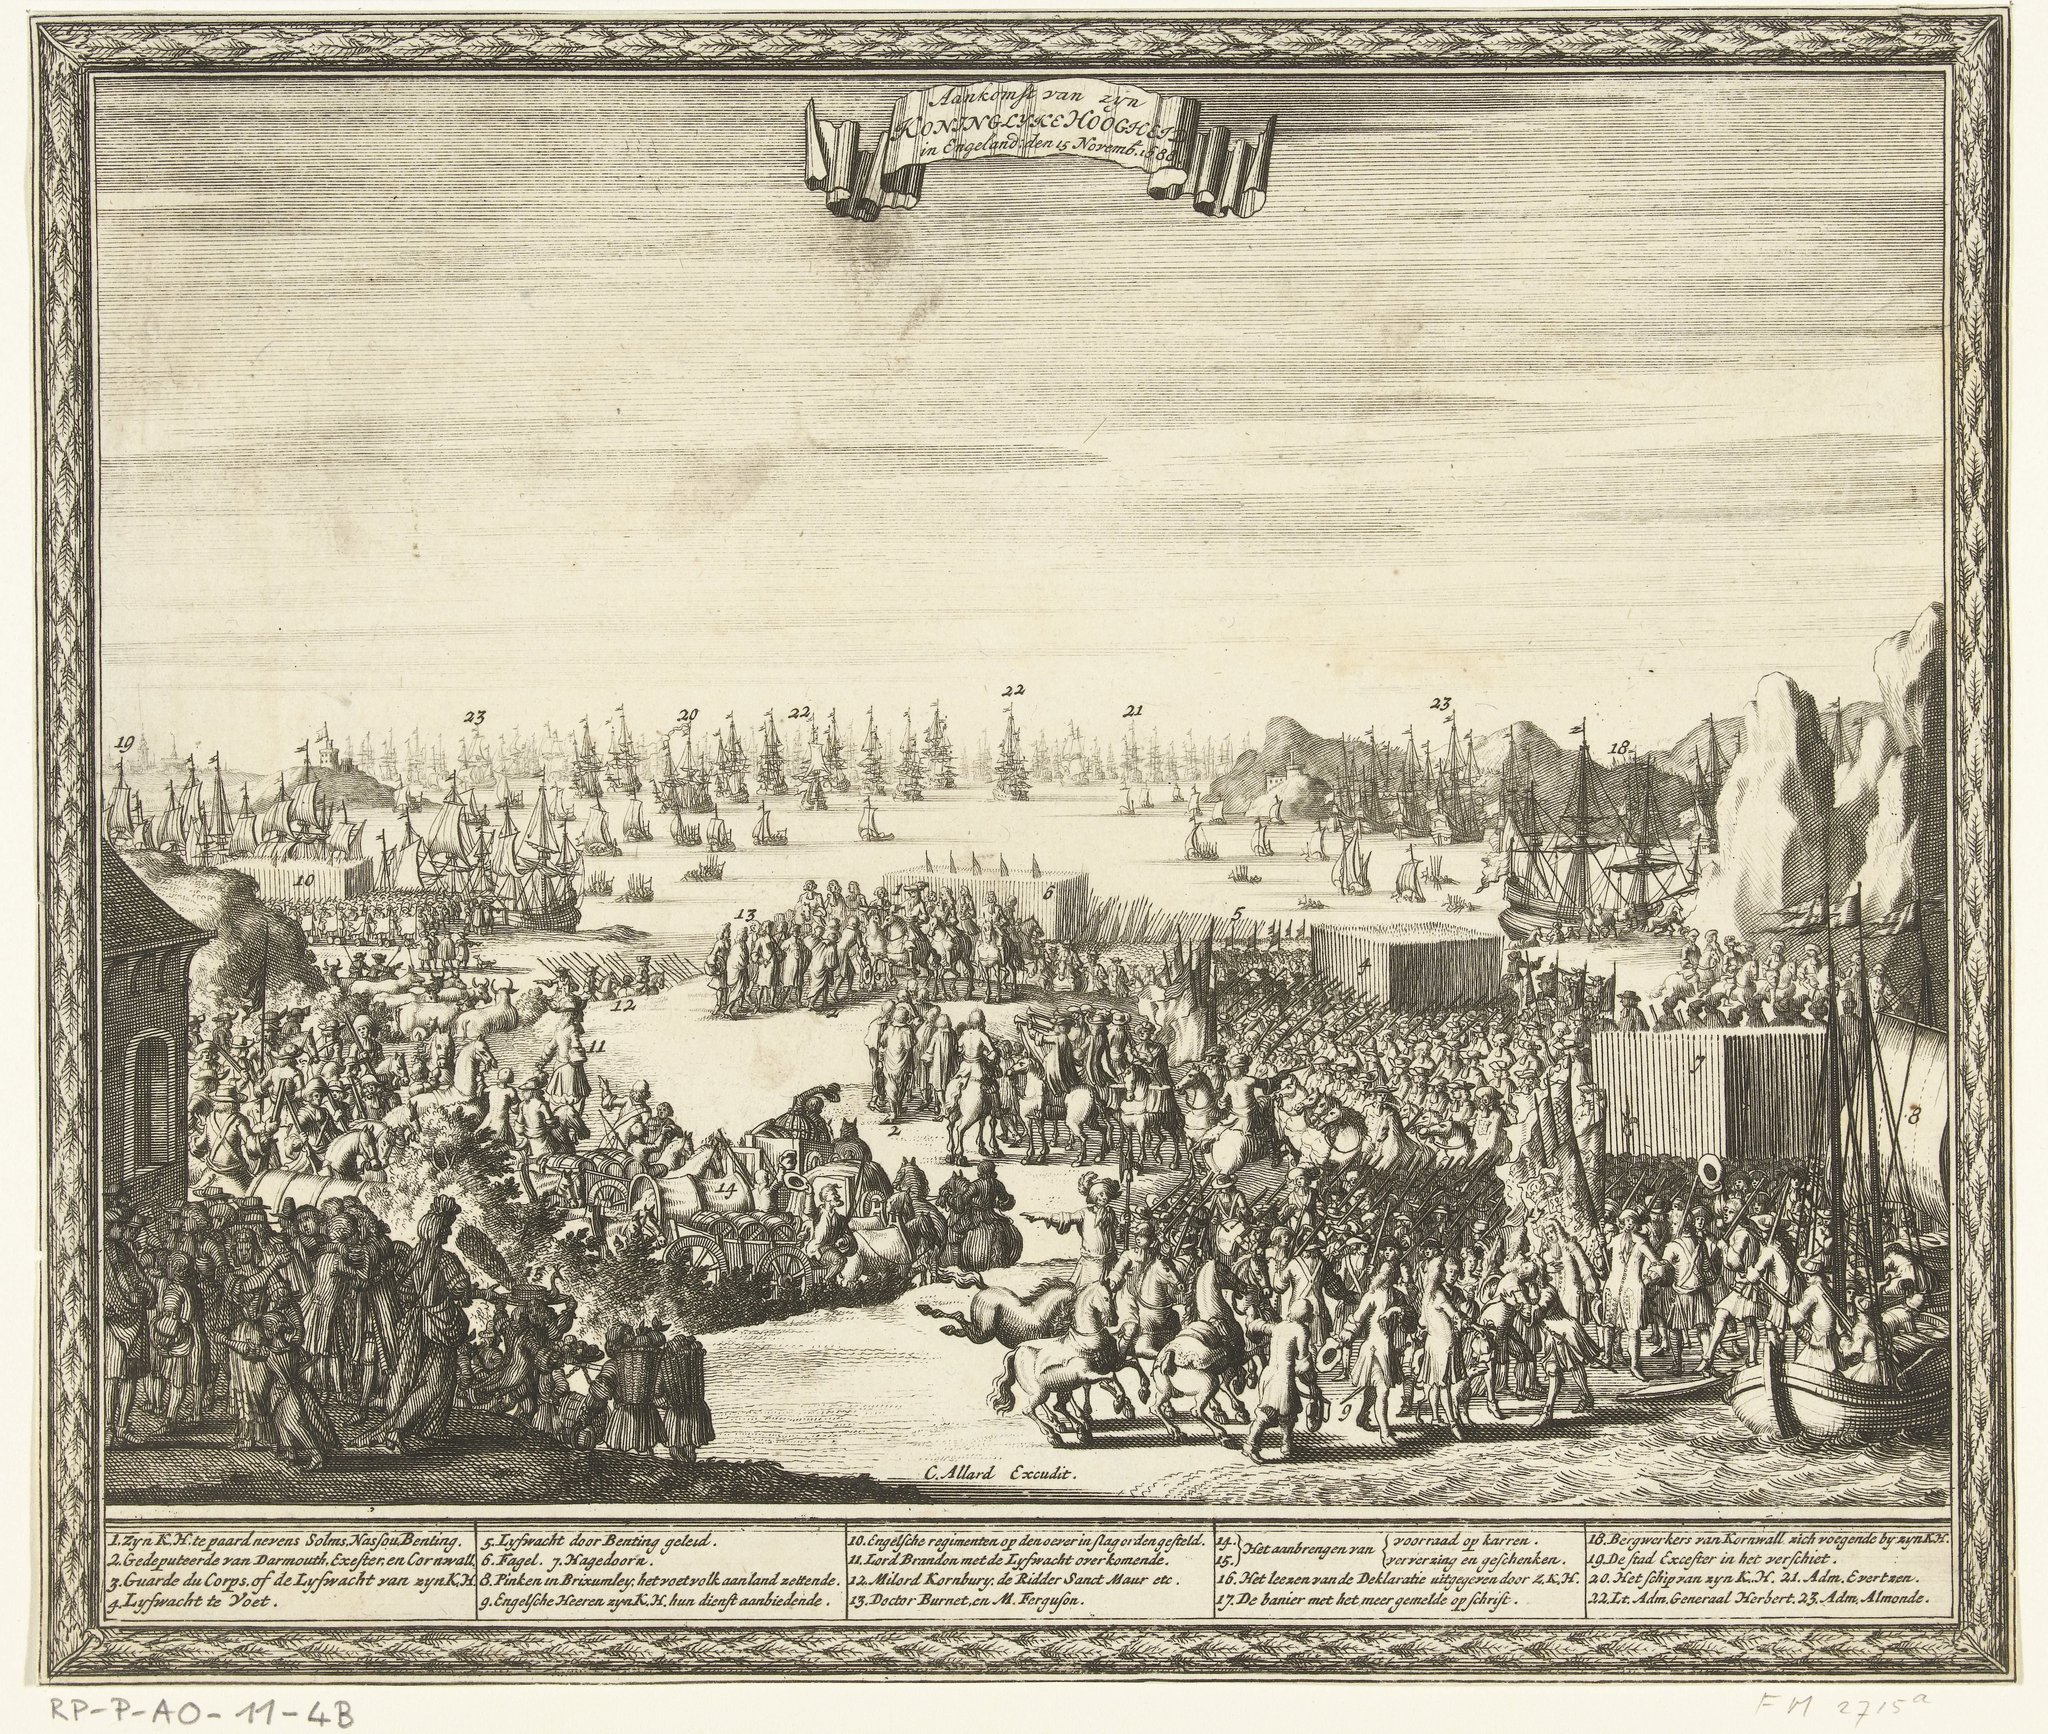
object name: print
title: Aankomst van zyn Koninglyke Hoogheid in Engeland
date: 1688-1700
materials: paper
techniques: etching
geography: amsterdam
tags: william iii (prince of orange and king of england, scotland, and ireland)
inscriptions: collector's mark: Lugt 2228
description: De vloot van Willem III arriveert in de haven van Brixham. De kade is bevolkt door troepen te voet en te paard. In het midden Willem III te paard op een heuvel. In de ondermarge een legenda van vijf kolommen van elk vier regels in het Nederlands.